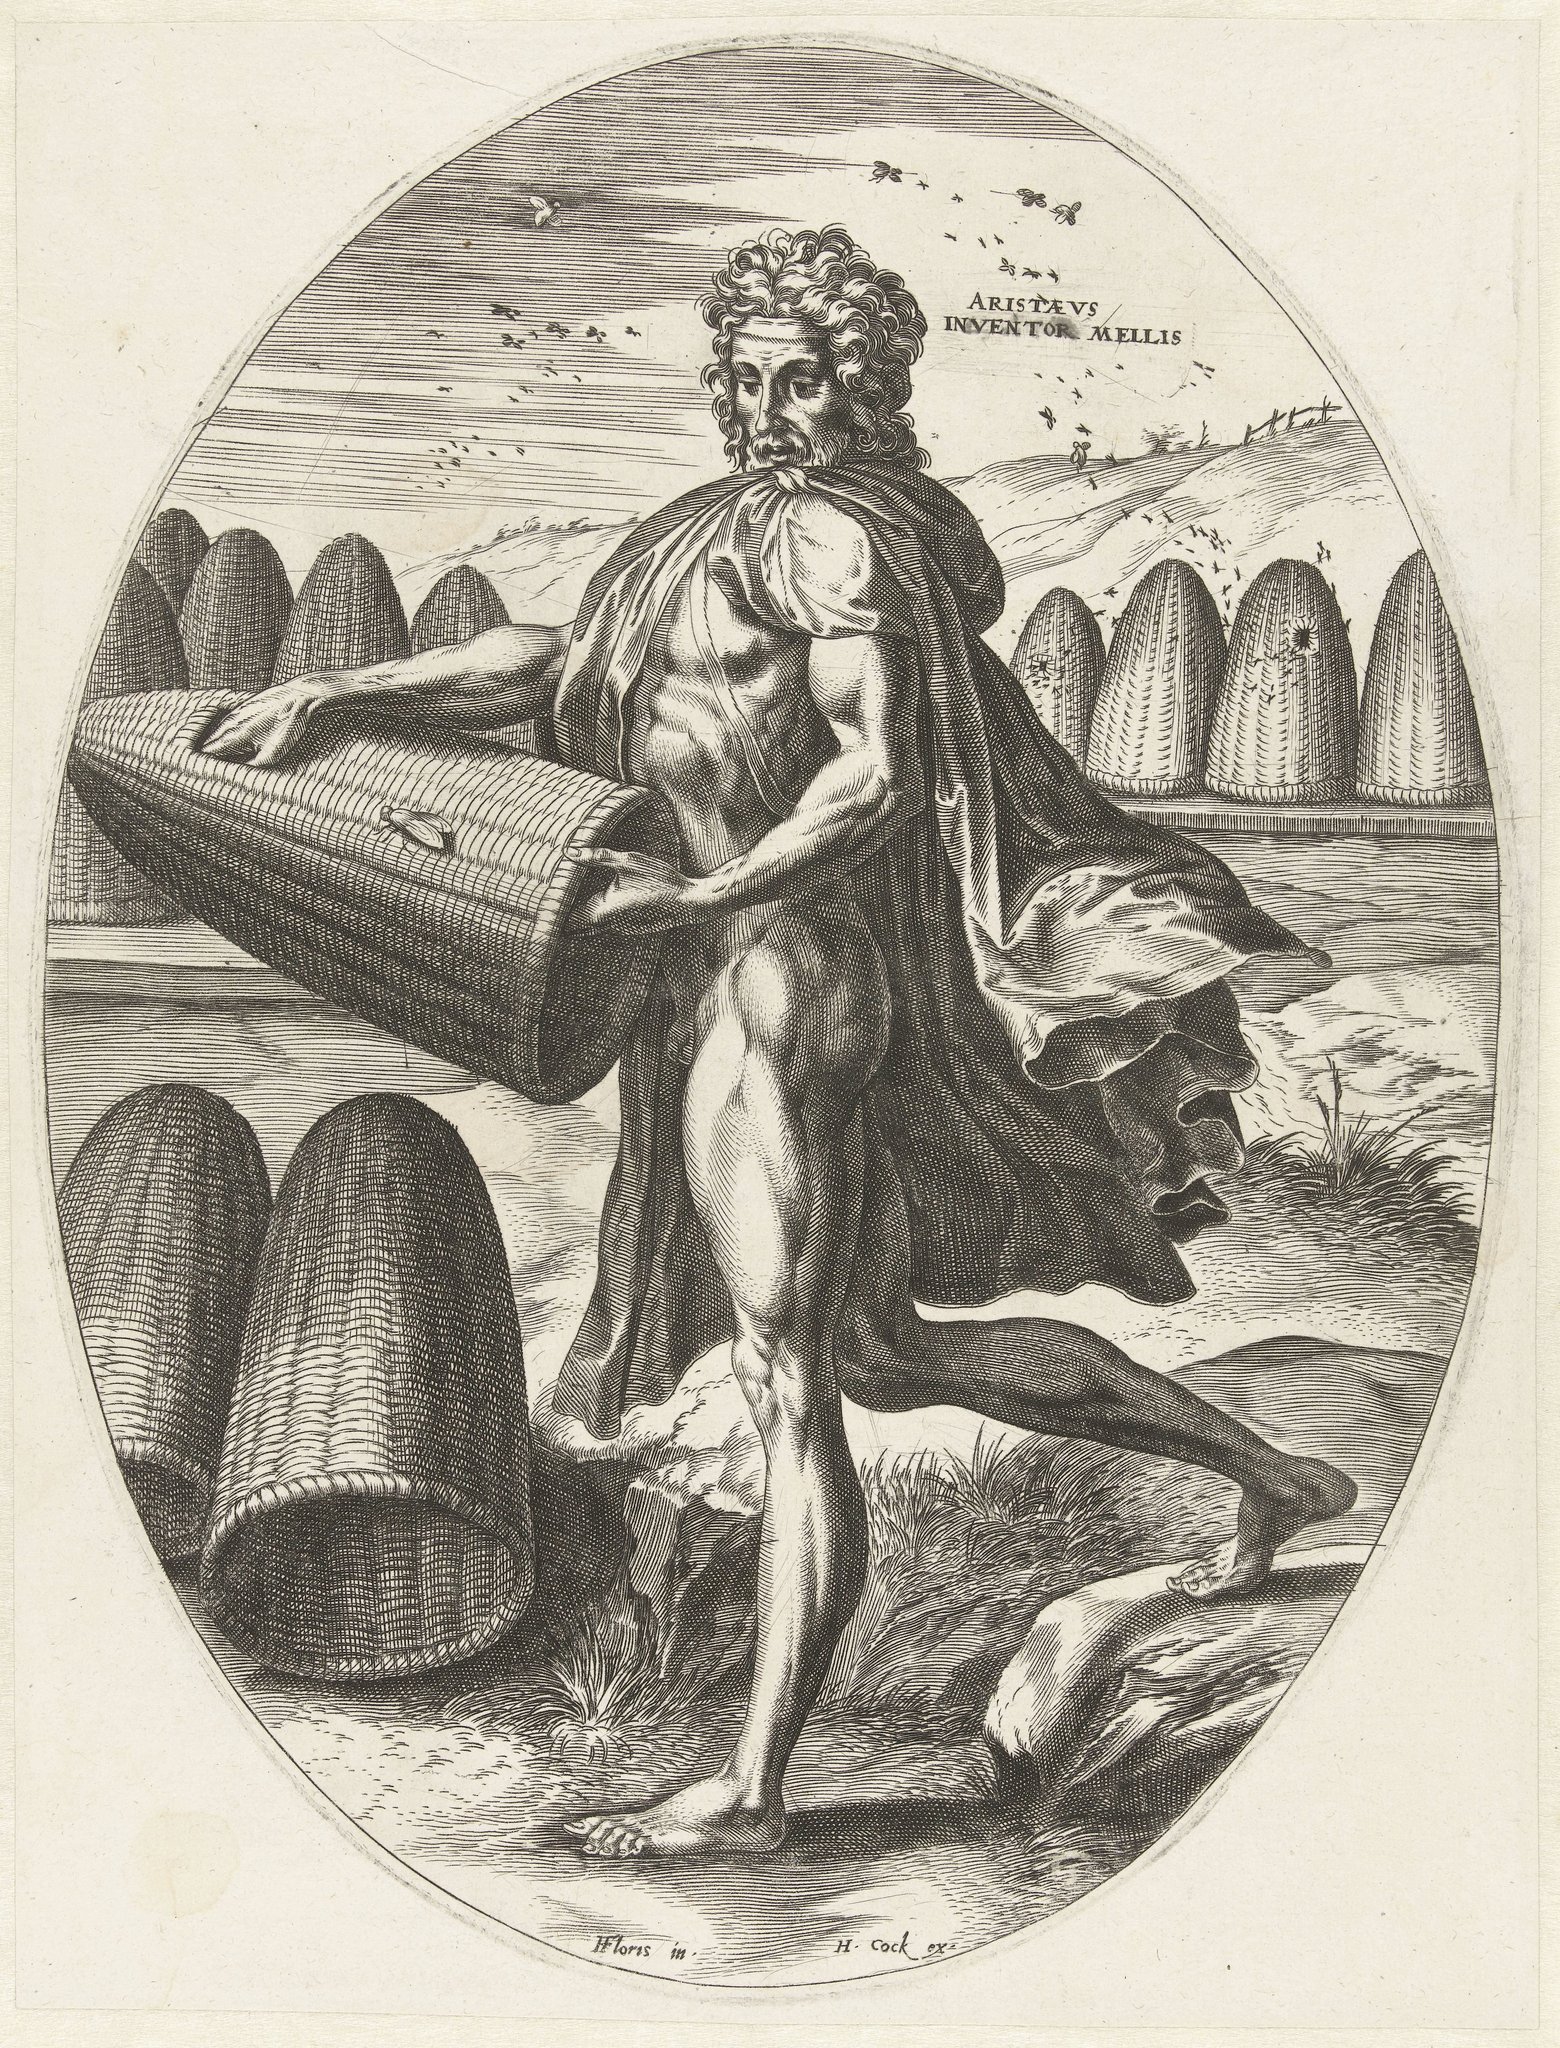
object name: print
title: Goden van de landbouw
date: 1565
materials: paper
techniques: engraving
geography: antwerp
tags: (story of) aristaeus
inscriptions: collector's mark: Lugt 1379, collector's mark: Lugt 2228, collector's mark: Lugt 2542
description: De sater Aristaeus is bezig bijenkorven op te ruimen. Hij was een imker. Op de achtergrond een hele rij met bijenkorven en bijen die af en aan vliegen.